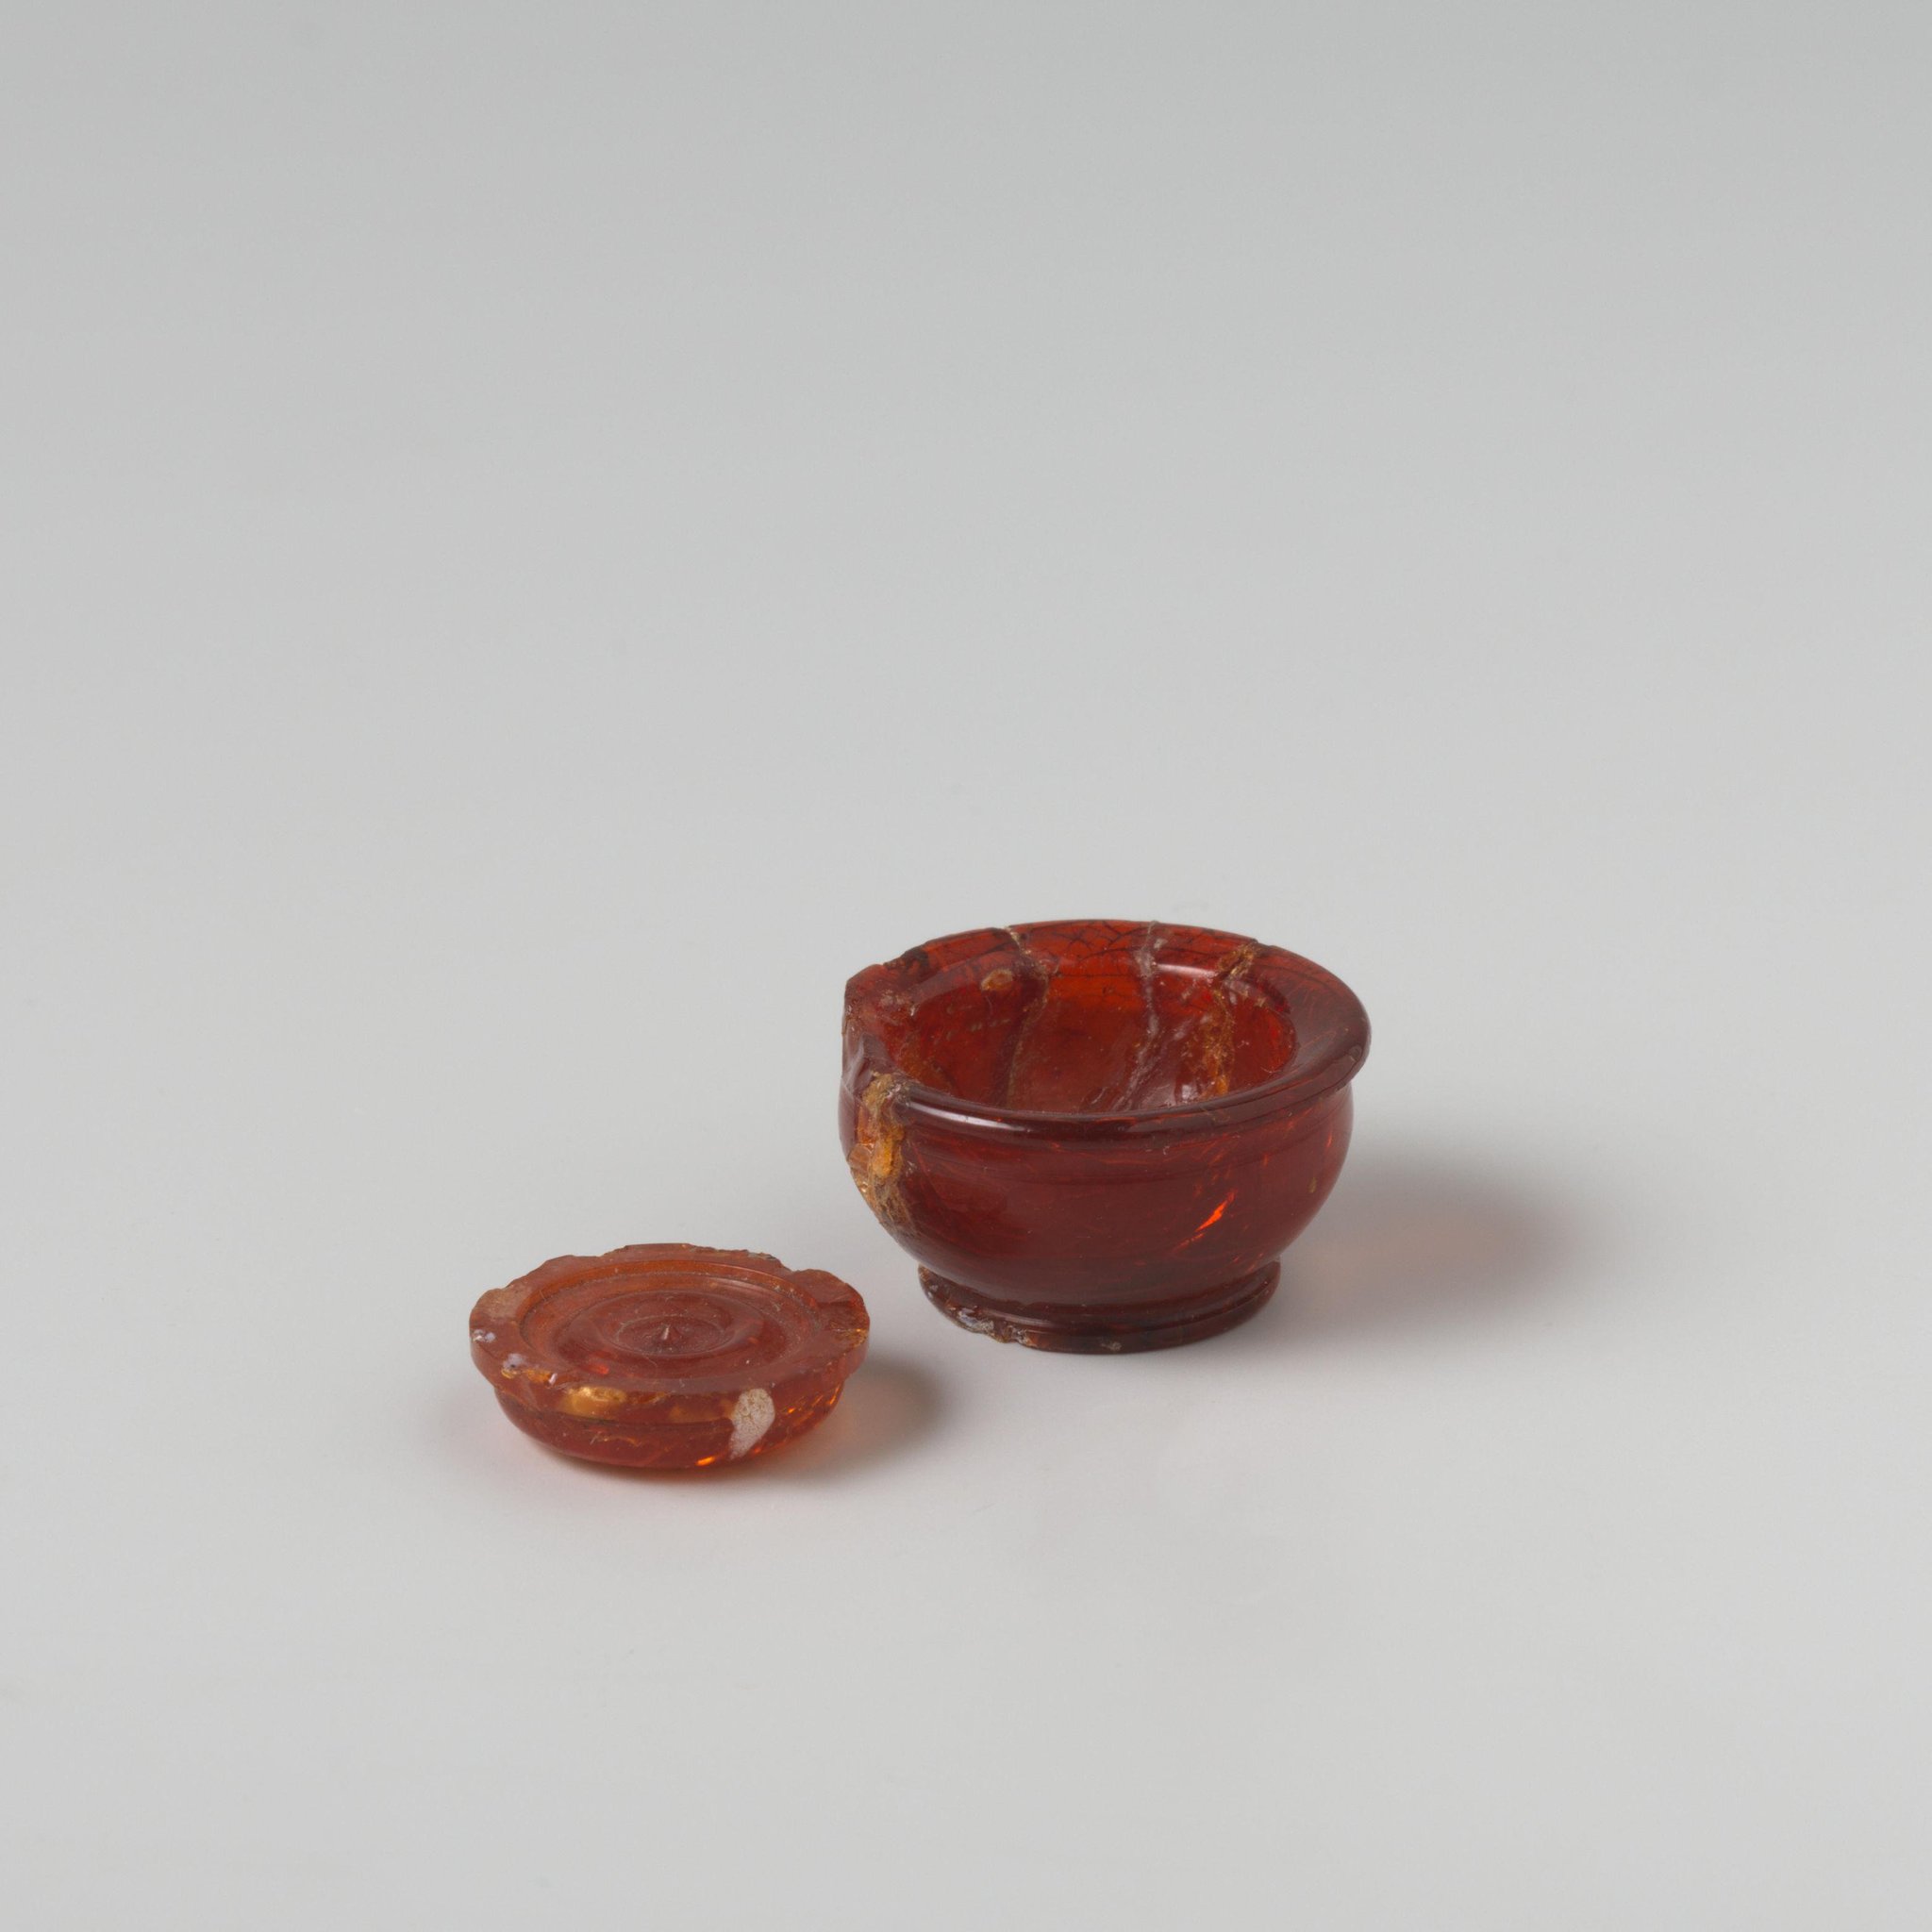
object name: miniature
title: Dekselkom met geprofileerd plat deksel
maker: Anonymous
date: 1650-1699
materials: amber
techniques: turning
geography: baltic sea region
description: Dekselkom vervaardigd van barnsteen, rond van vorm, met standring en uitstekende rand. Het platte deksel met ingegroefde profilering.